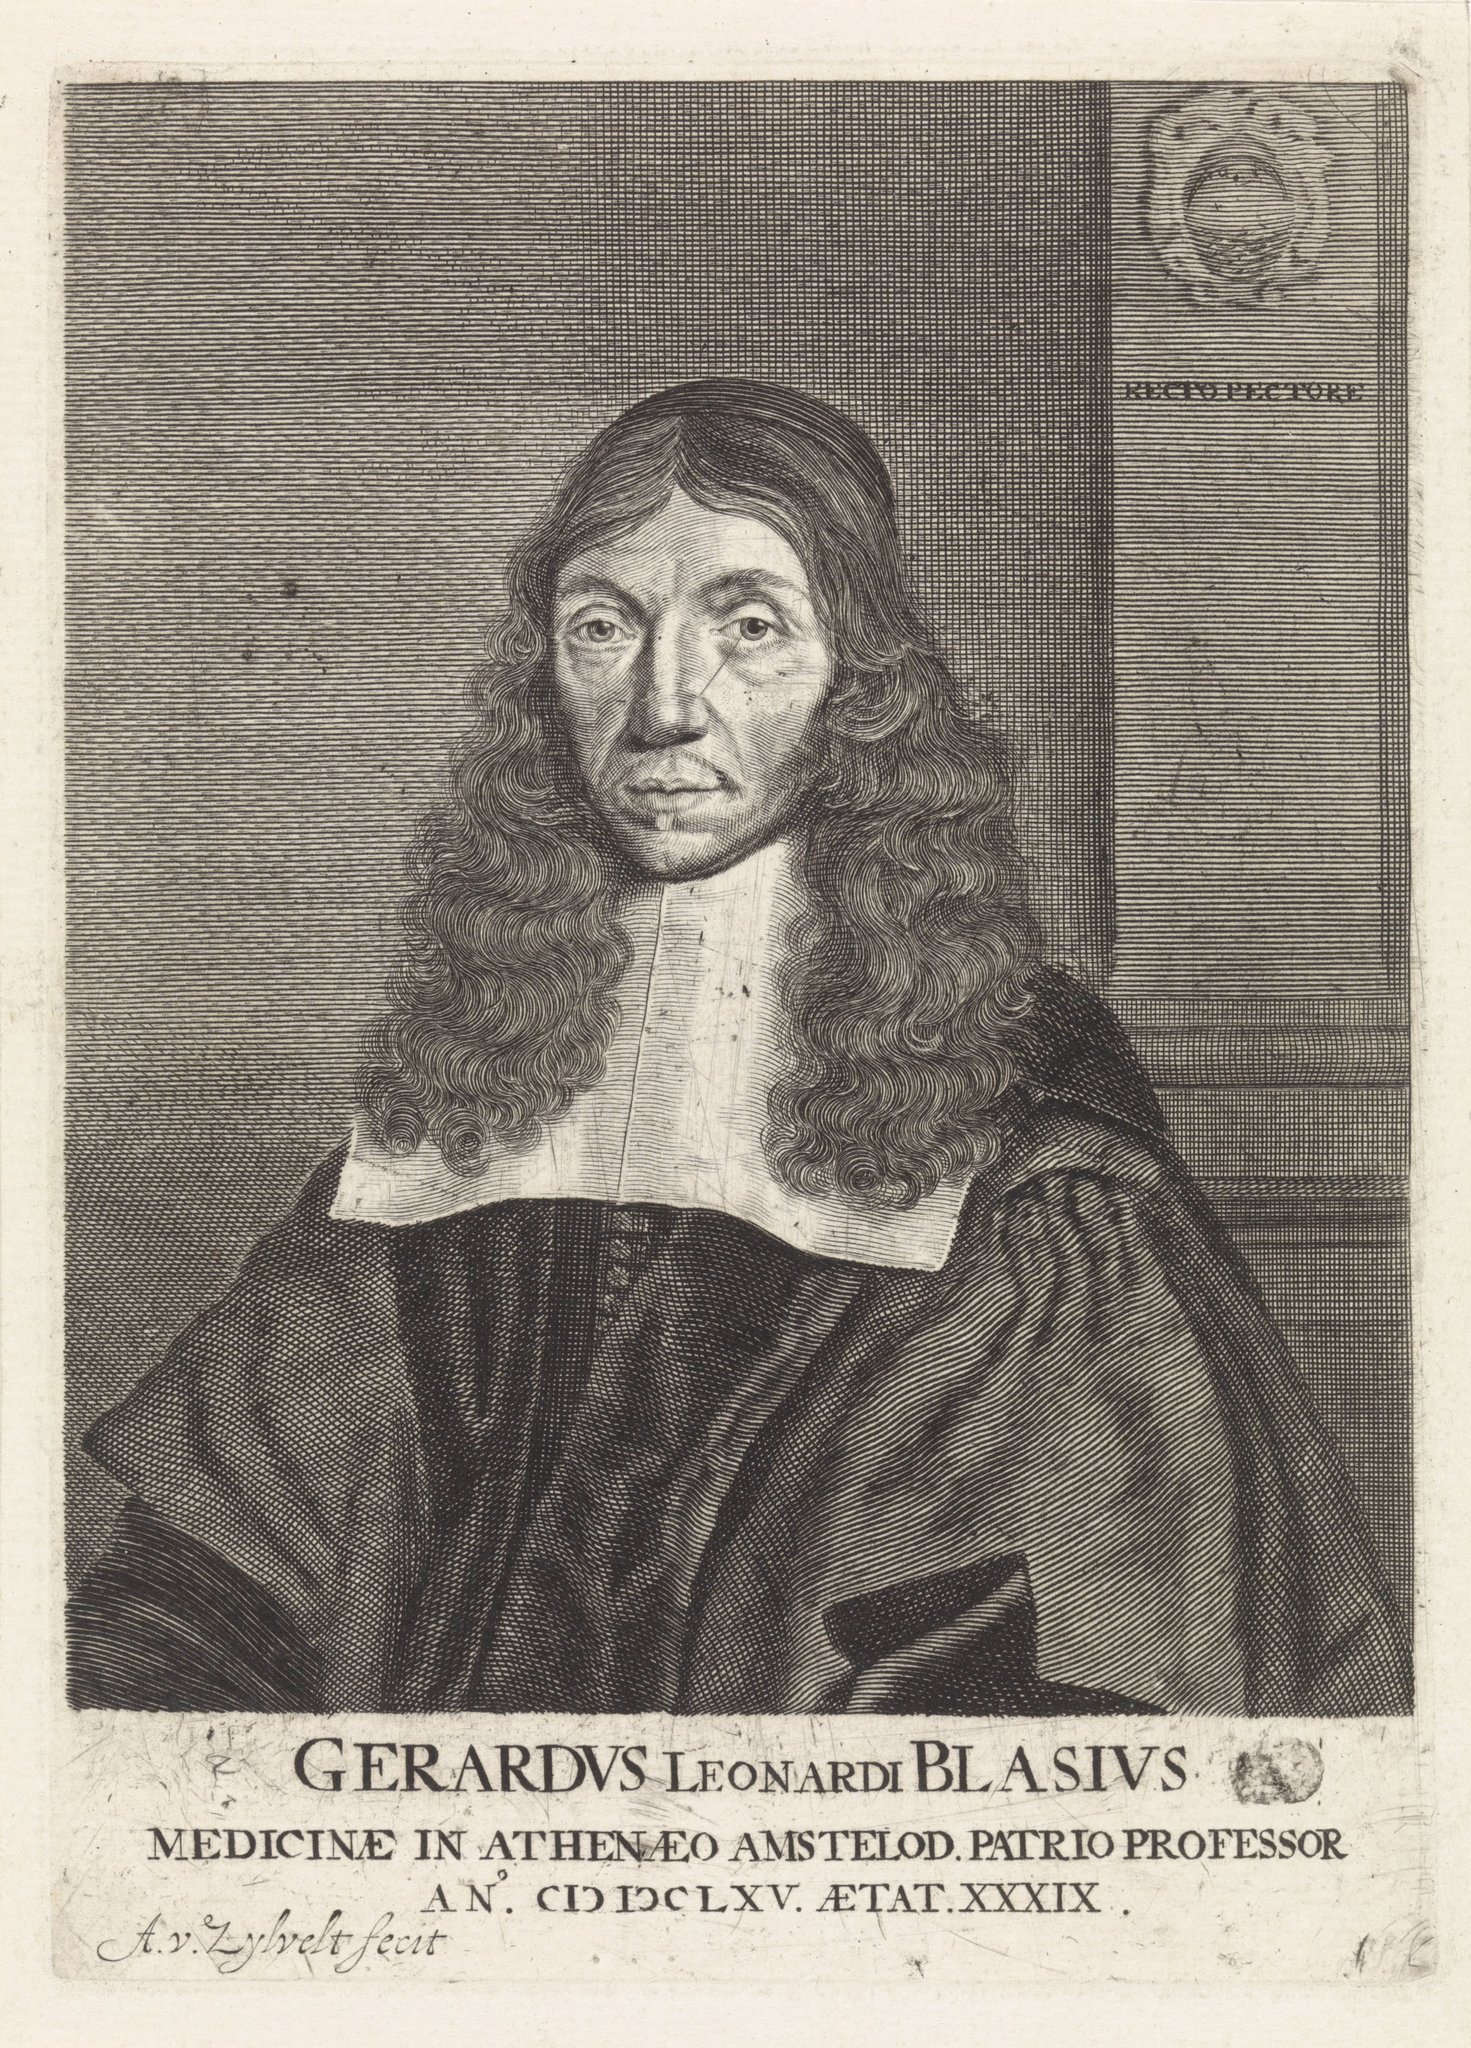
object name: print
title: Portret van Gerardus Blasius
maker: anthony van zijlvelt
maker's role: print maker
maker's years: 1637-1715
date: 1665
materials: paper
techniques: engraving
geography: amsterdam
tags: aspects of science in general (+ portrait of scholar, scientist), physician, doctor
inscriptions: title: ‘GERARDUS LEONARDI BLASIUS’, collector's mark: Lugt 2228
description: Gerardus Blasius, arts en hoogleraar aan het athenaeum van Amsterdam, op 39-jarige leeftijd. Rechtsachter een zuil met zijn wapen en motto: recto pectore. Midden onder in marge zijn naam en functie.